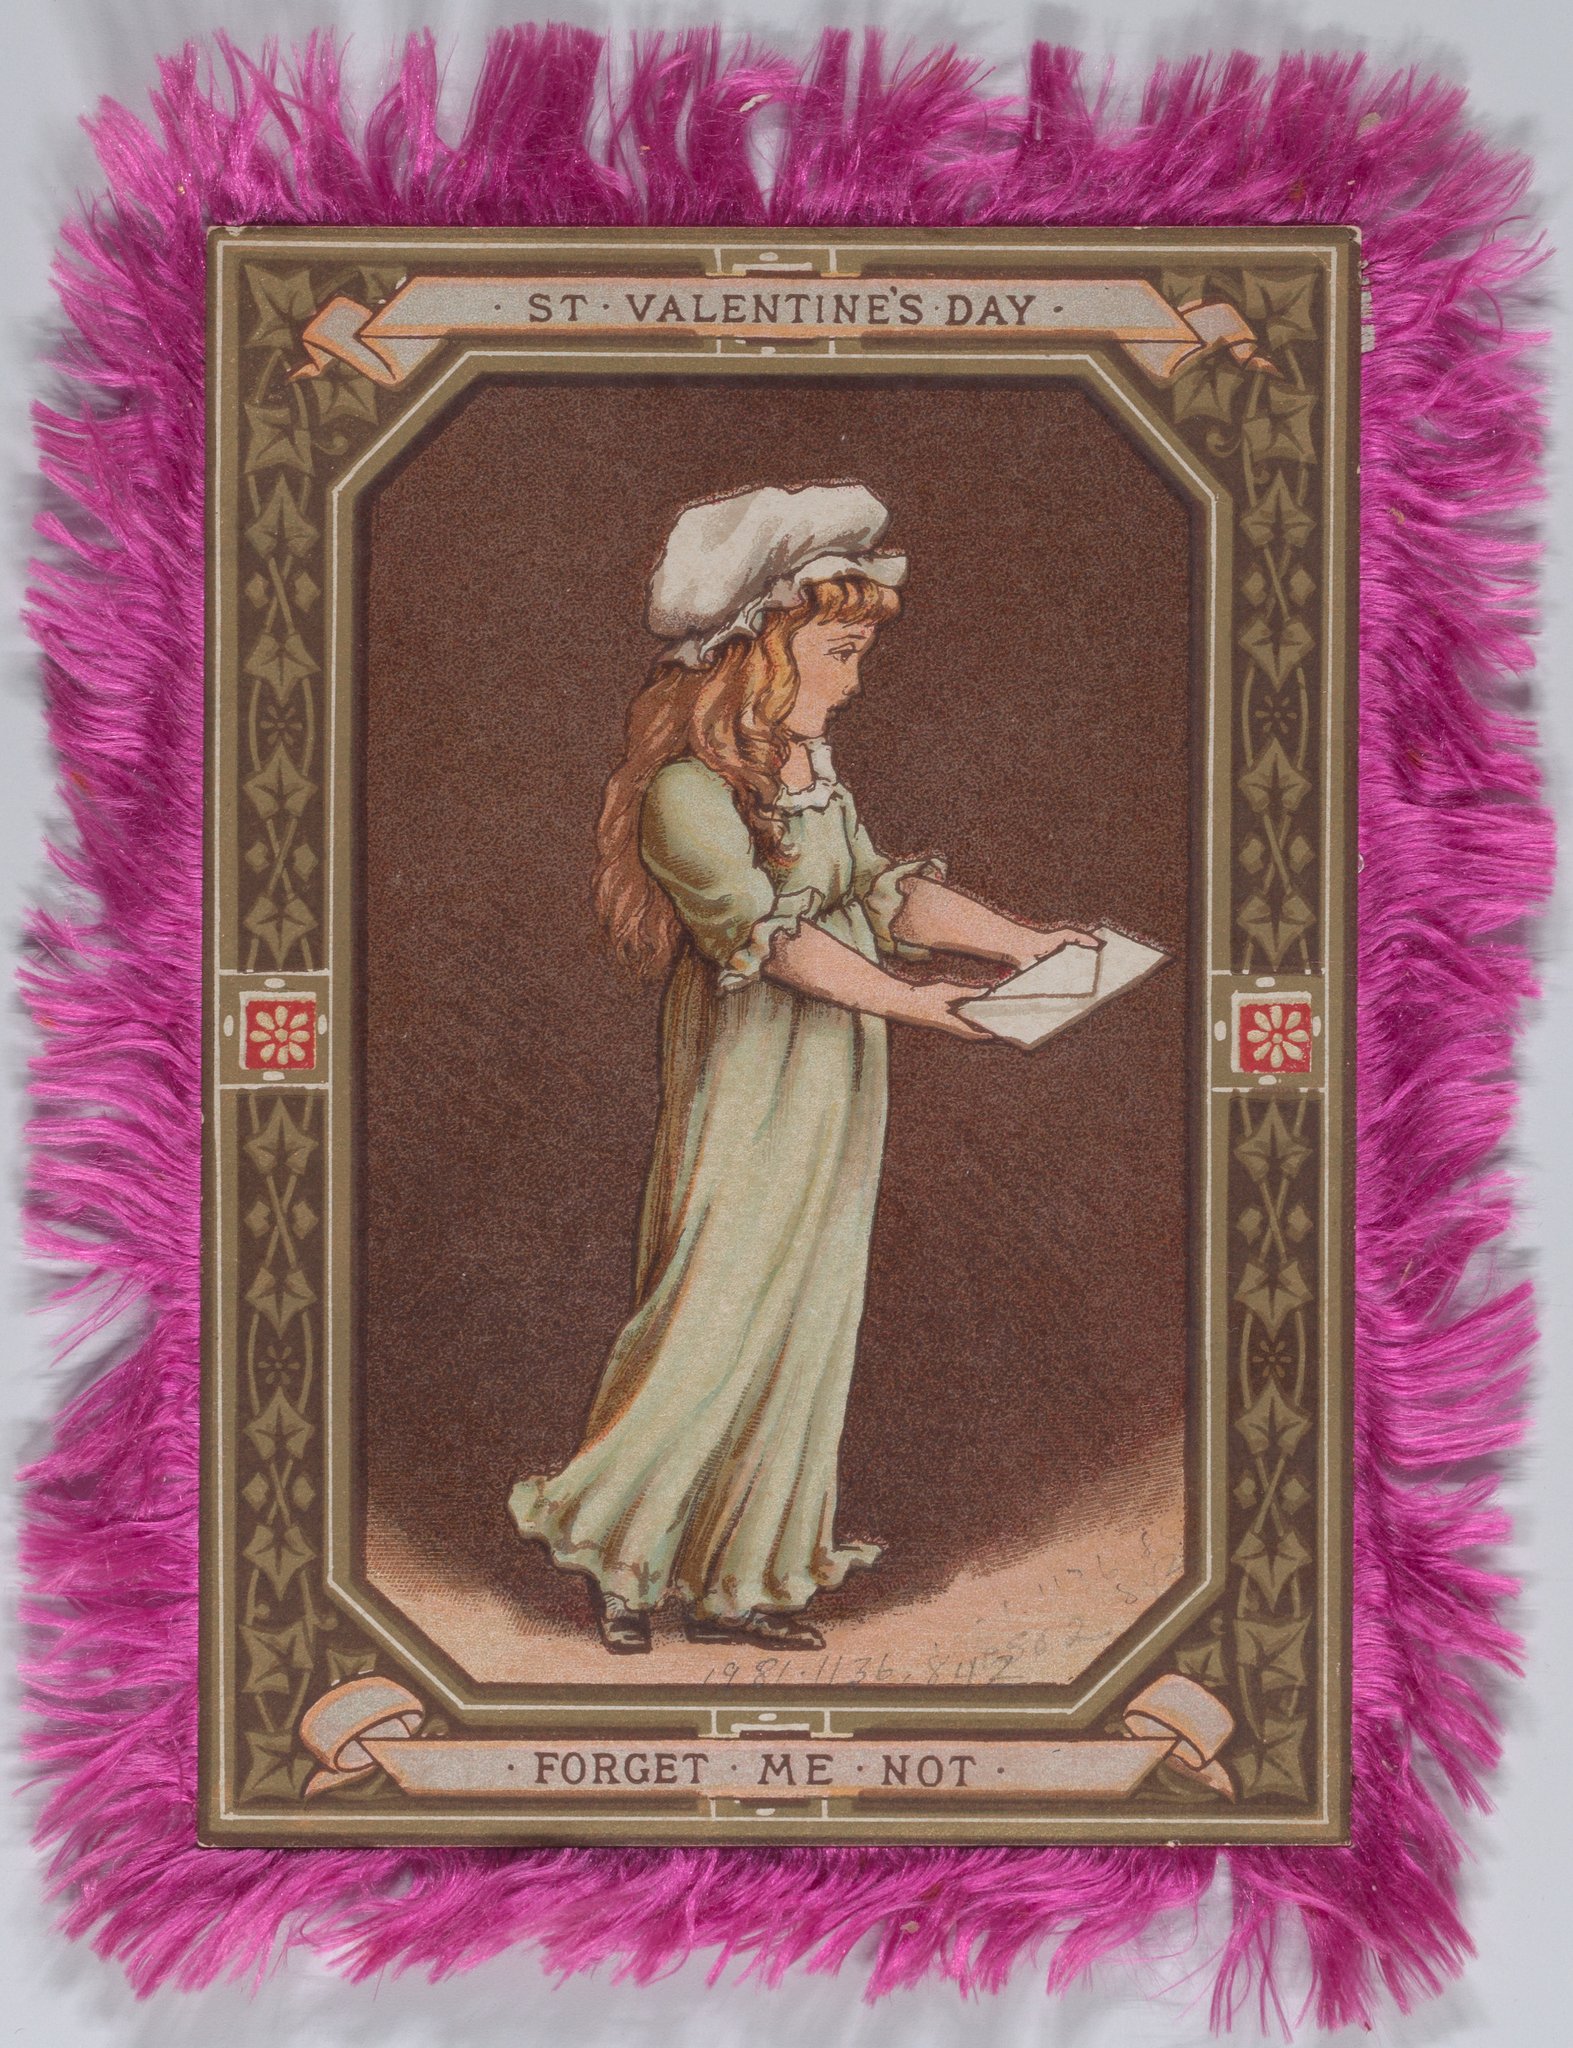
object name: valentine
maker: kate greenaway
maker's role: artist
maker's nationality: british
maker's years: 1846-1901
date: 1879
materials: gold, silk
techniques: chromolithography, lithograph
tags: girls